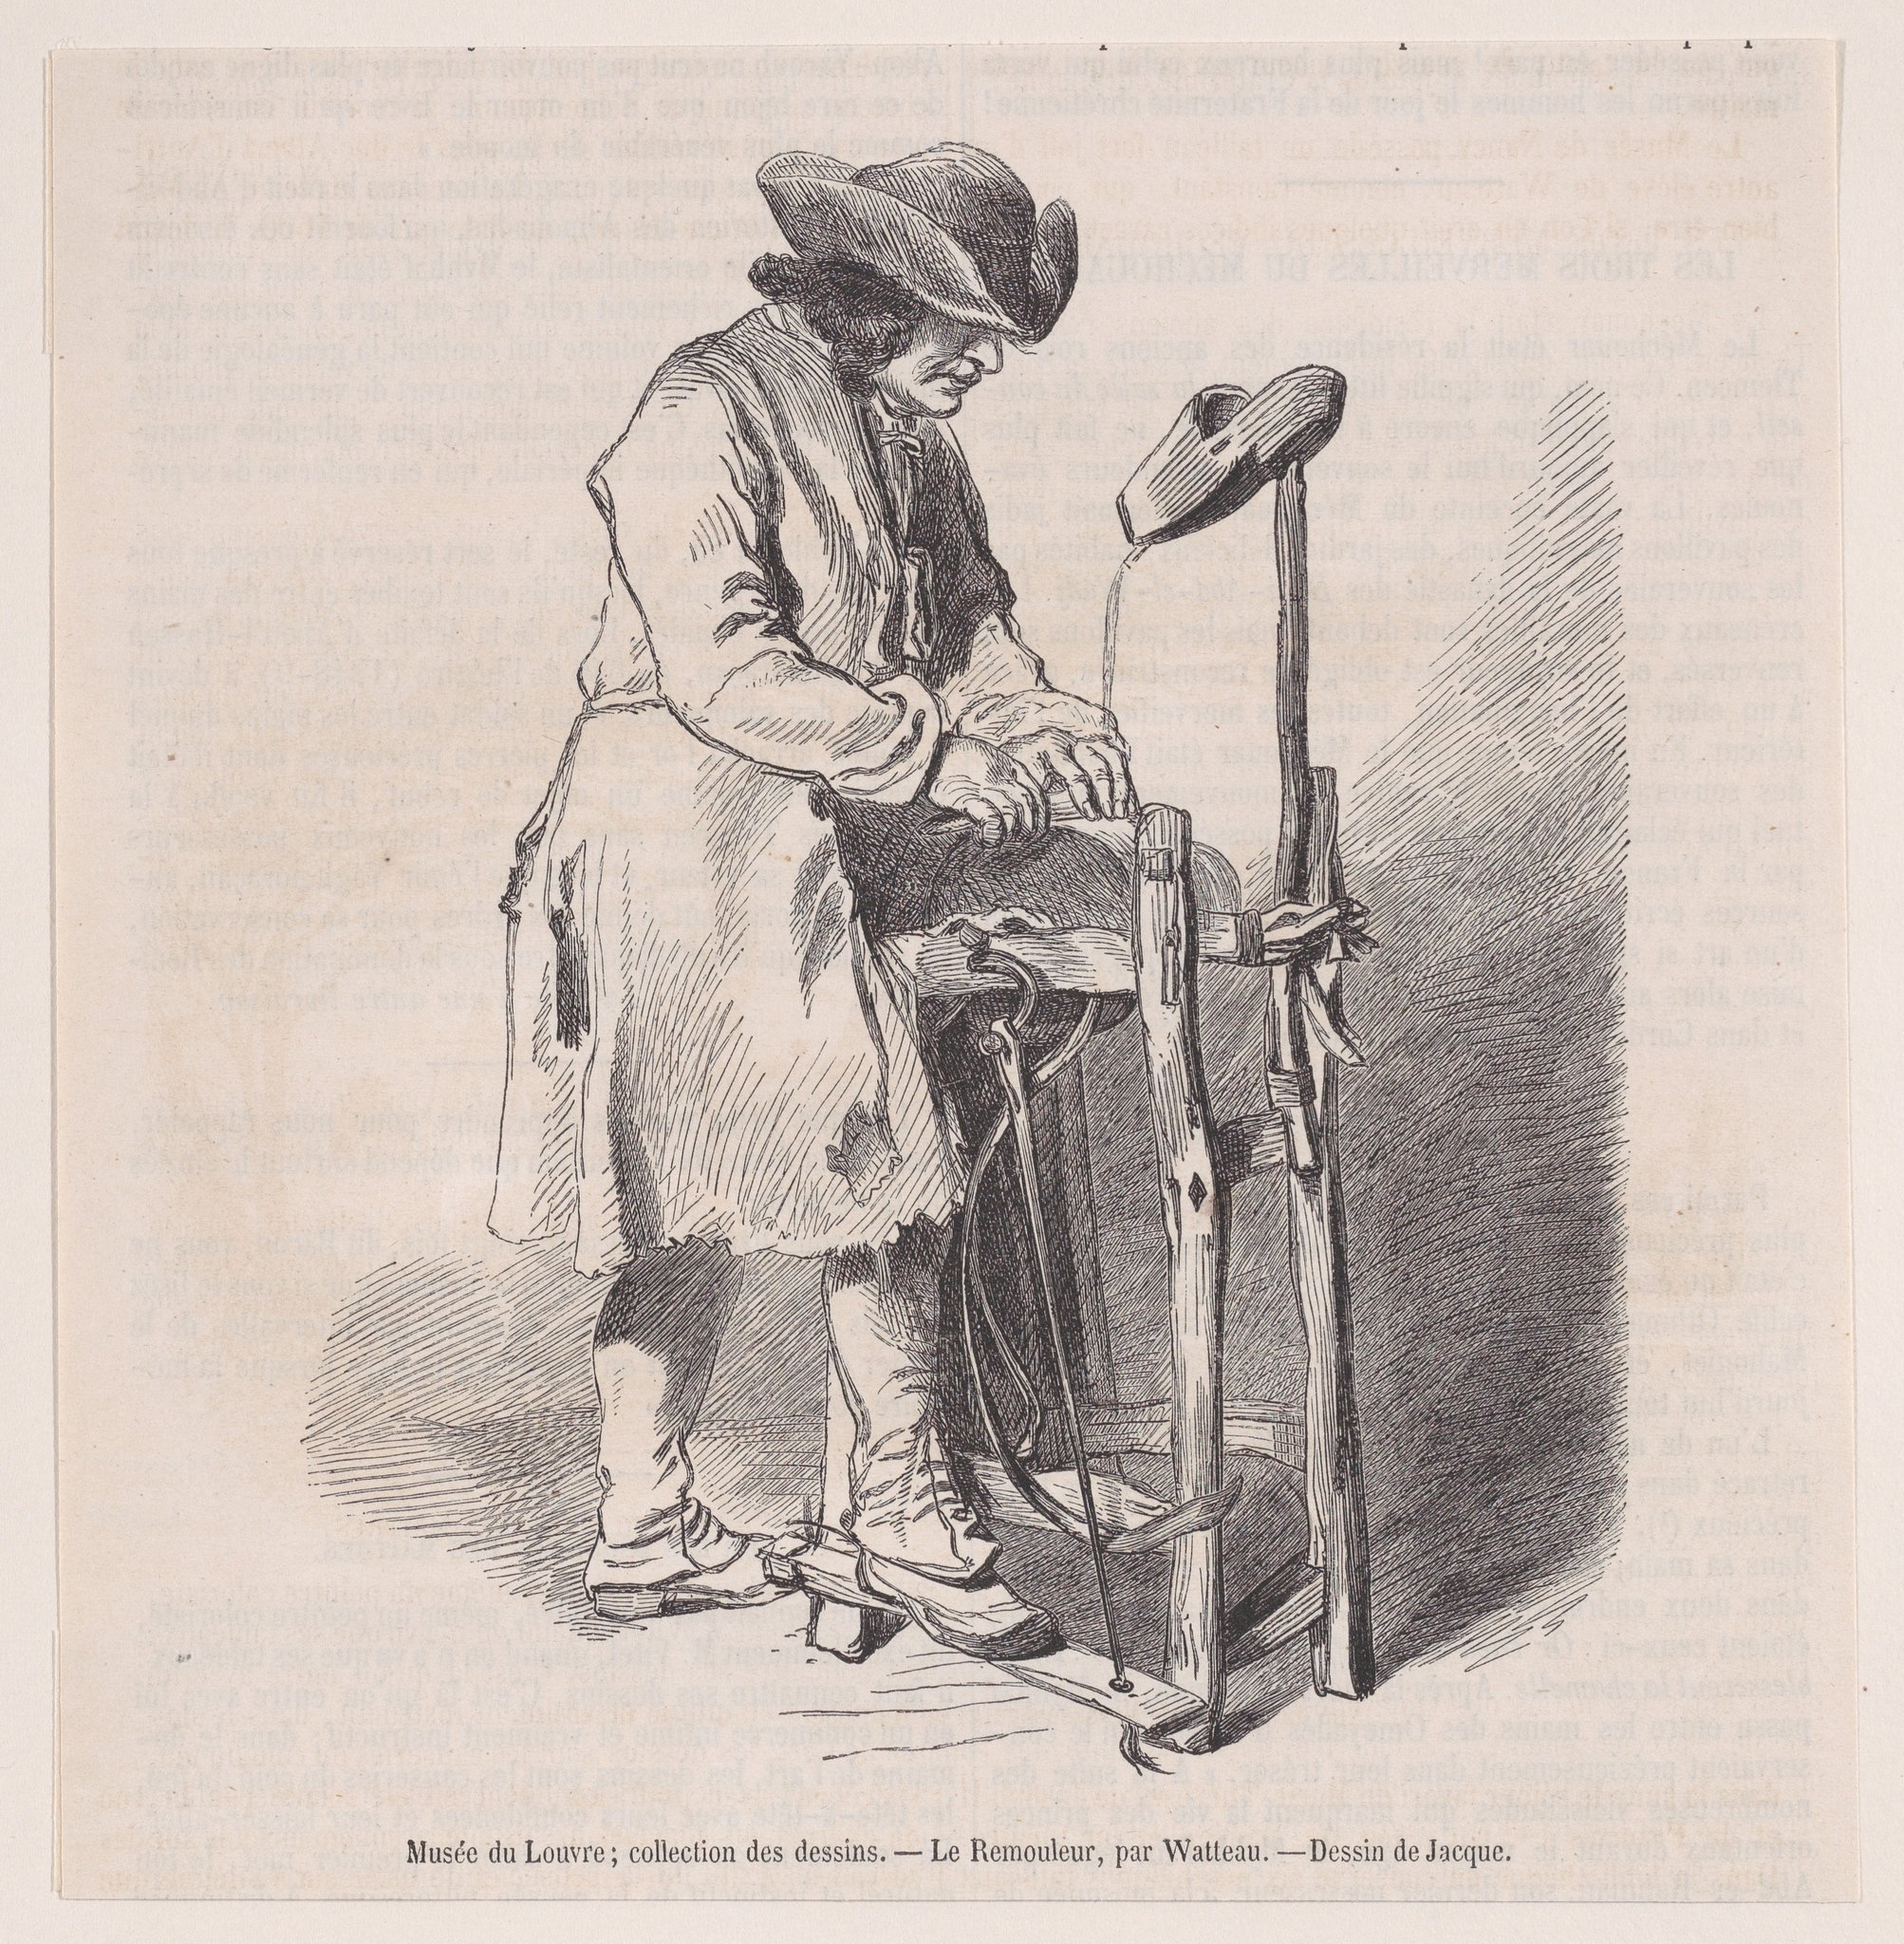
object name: print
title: Musée du Louvre; collection des dessins, Le Remouler, par Watteau, from "Le Magasin Pittoresque"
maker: charles émile jacque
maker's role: artist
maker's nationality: french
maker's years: 1813-1894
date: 1852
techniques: engraving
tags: men,machines